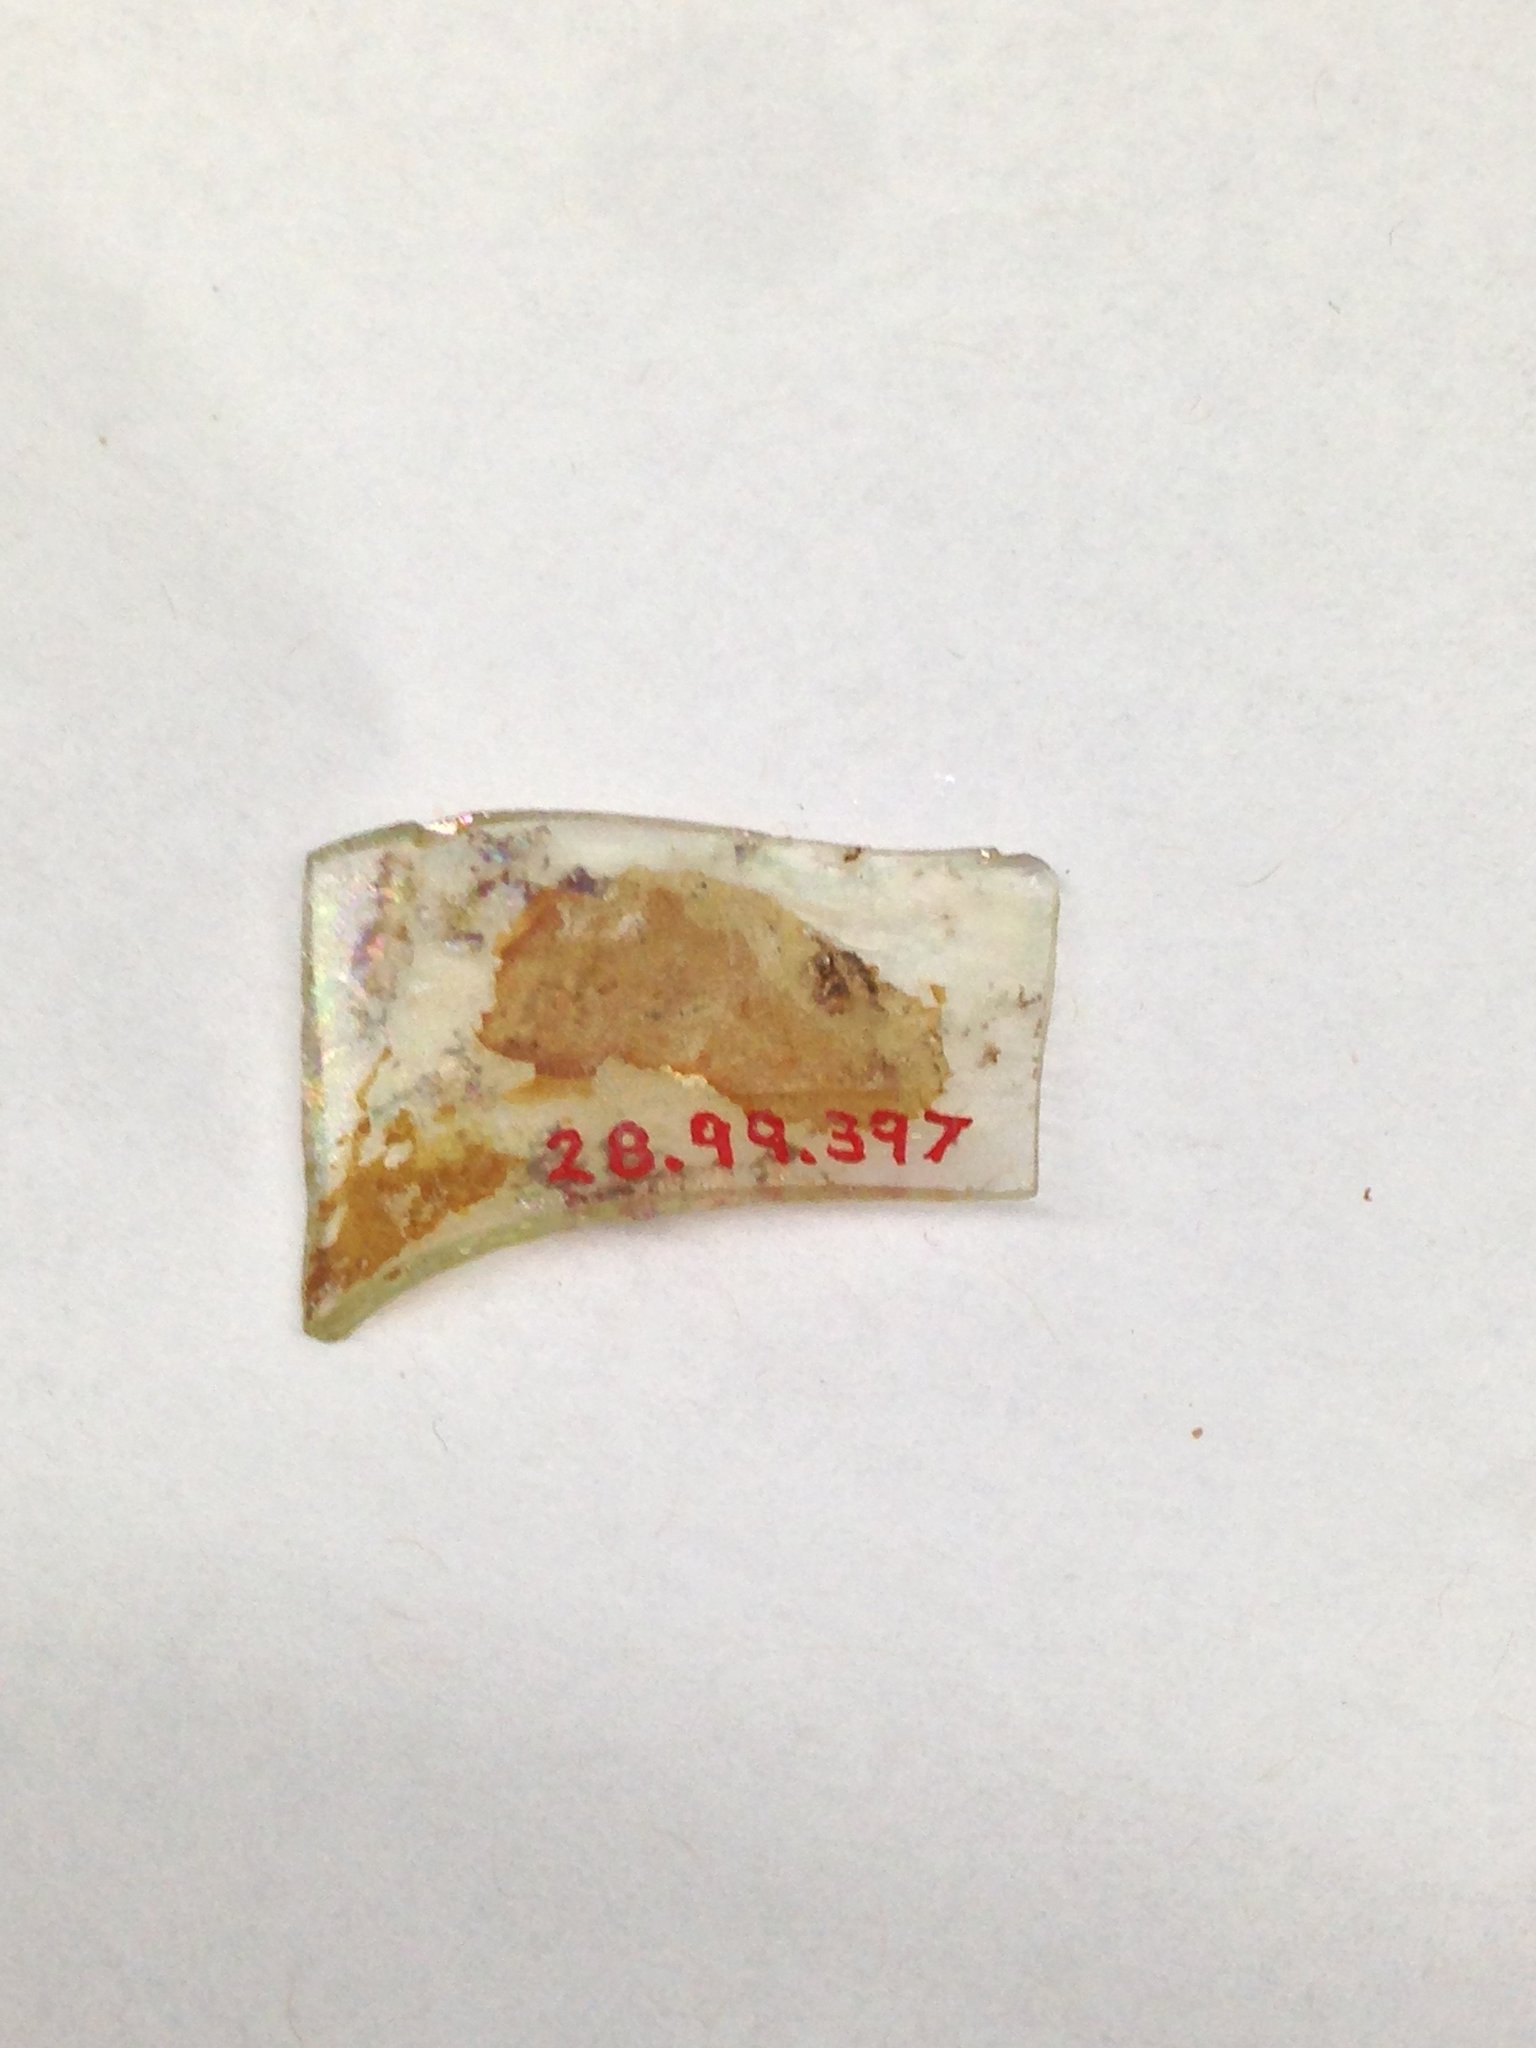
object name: fragment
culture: european or middle eastern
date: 1150-1250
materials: ceramic, glass